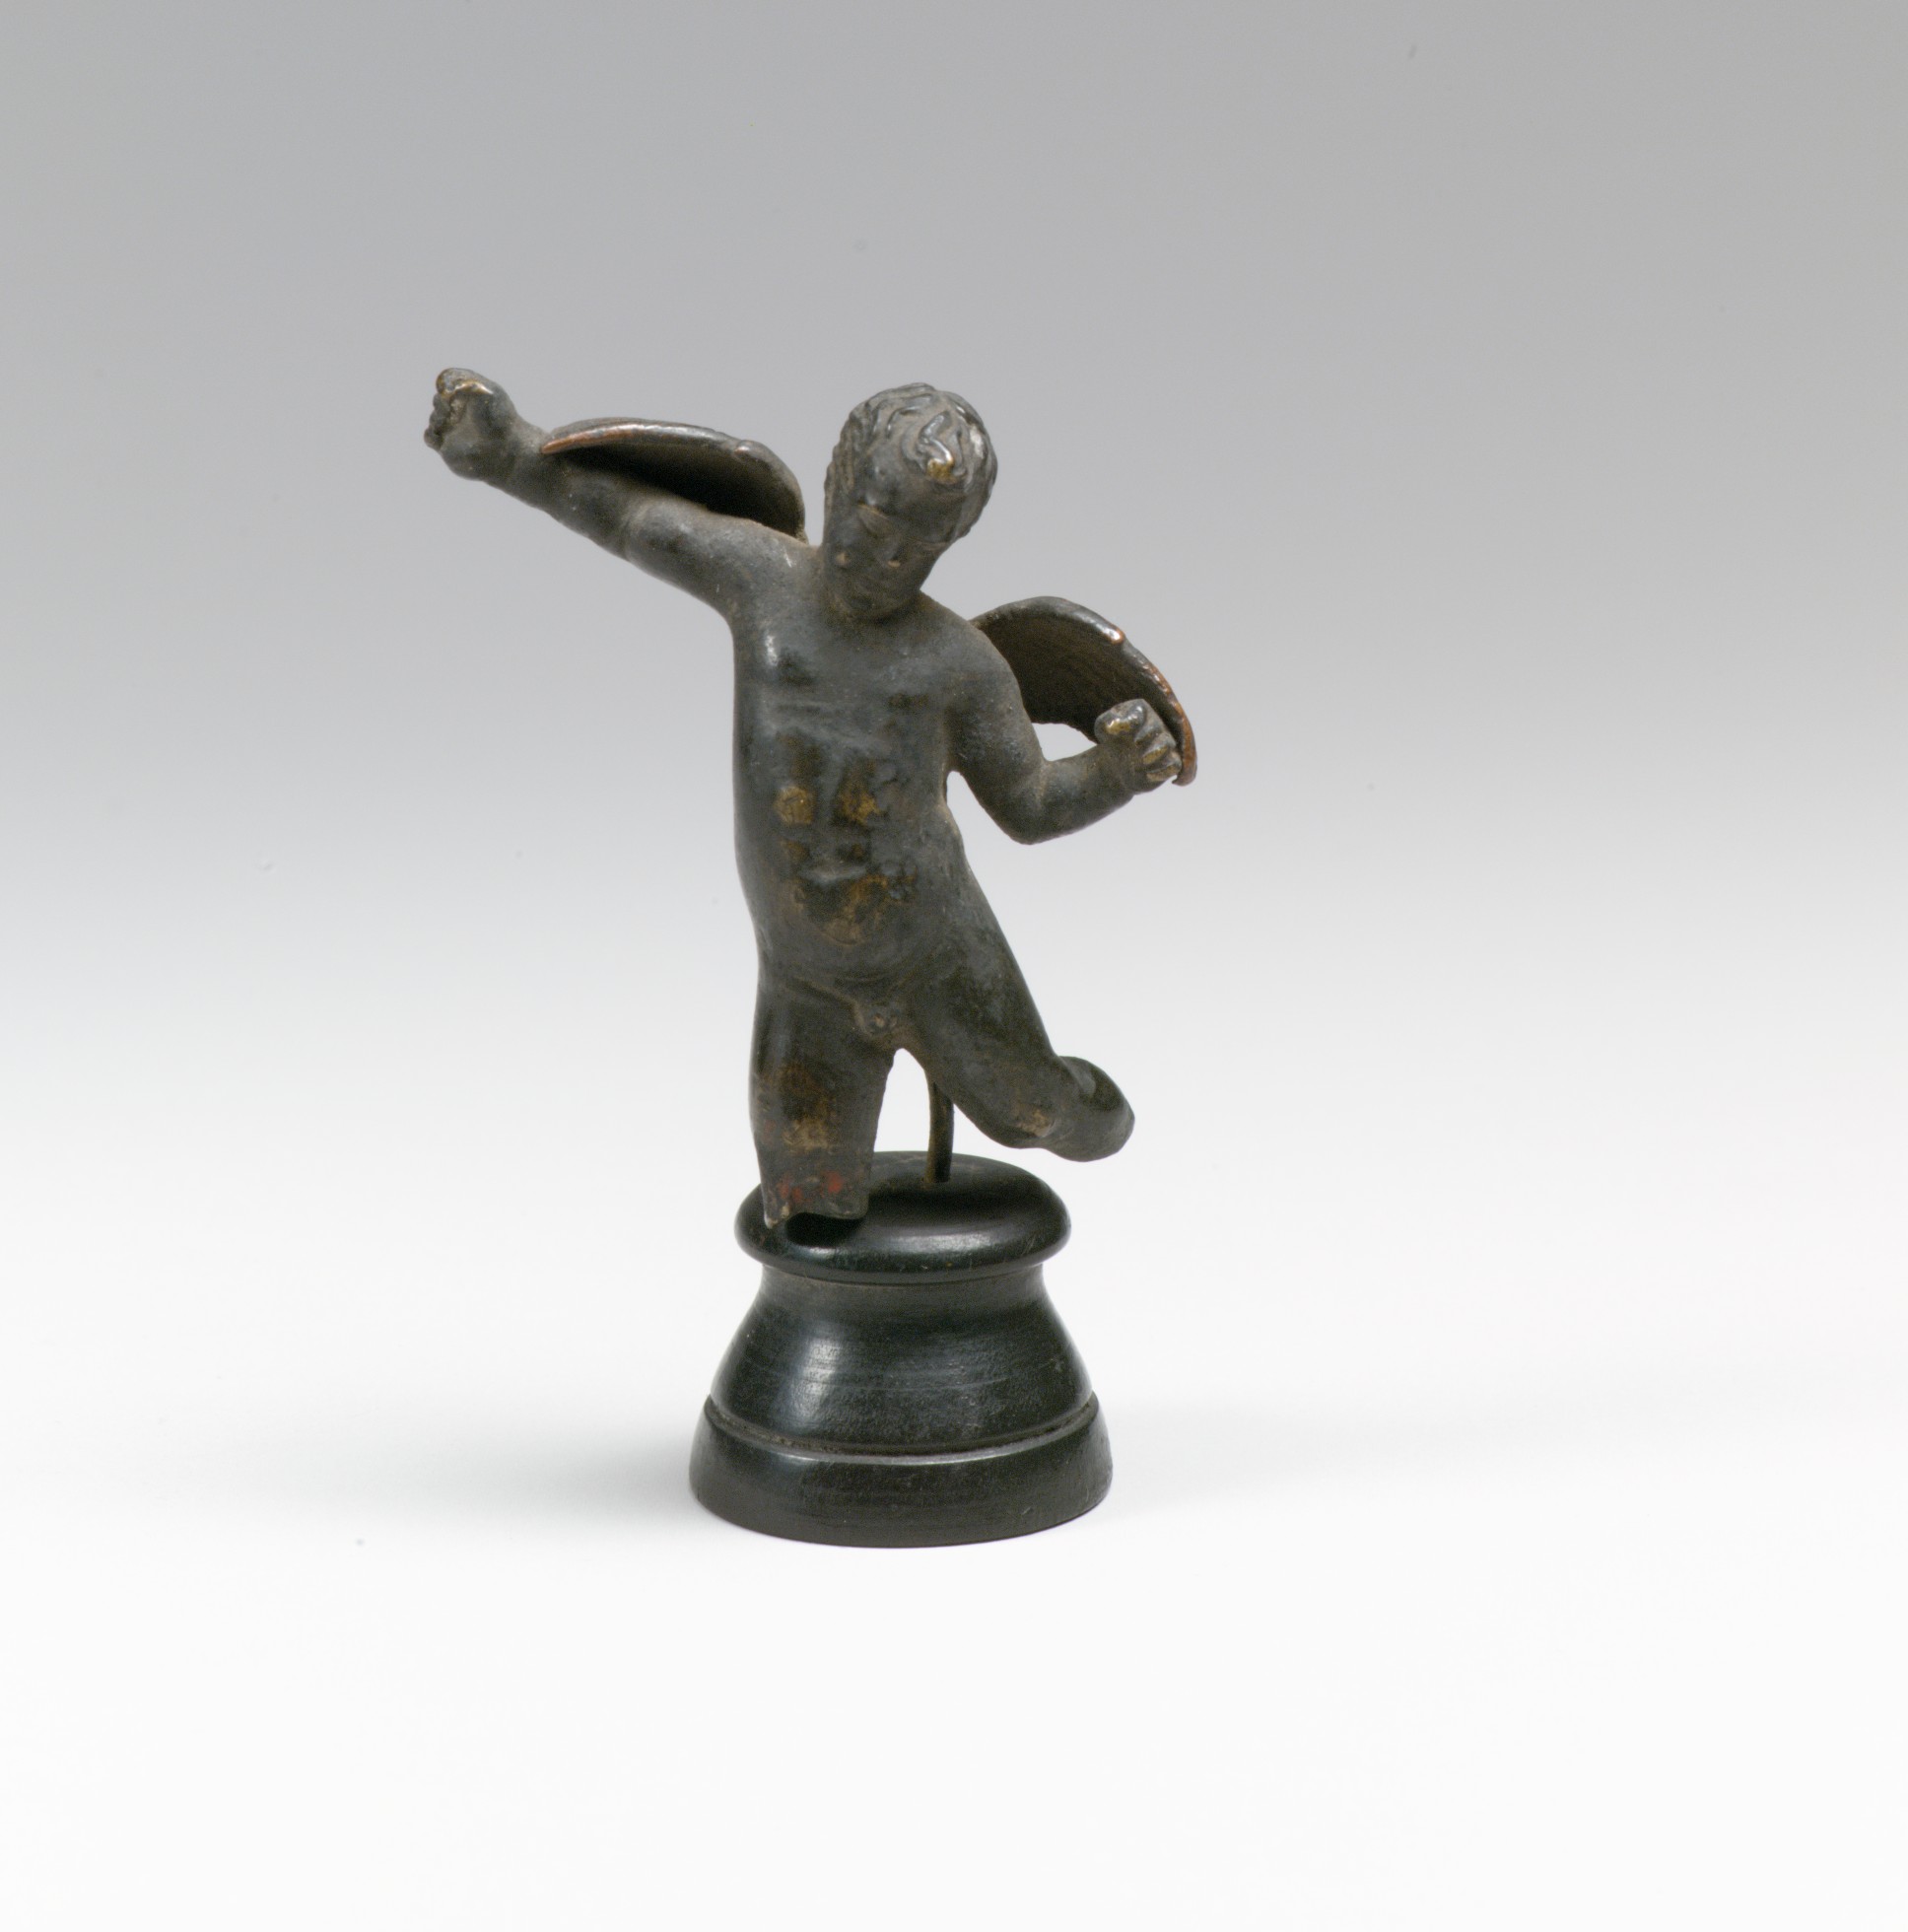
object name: statuette of eros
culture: greek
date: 7000-30 BCE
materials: bronze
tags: eros